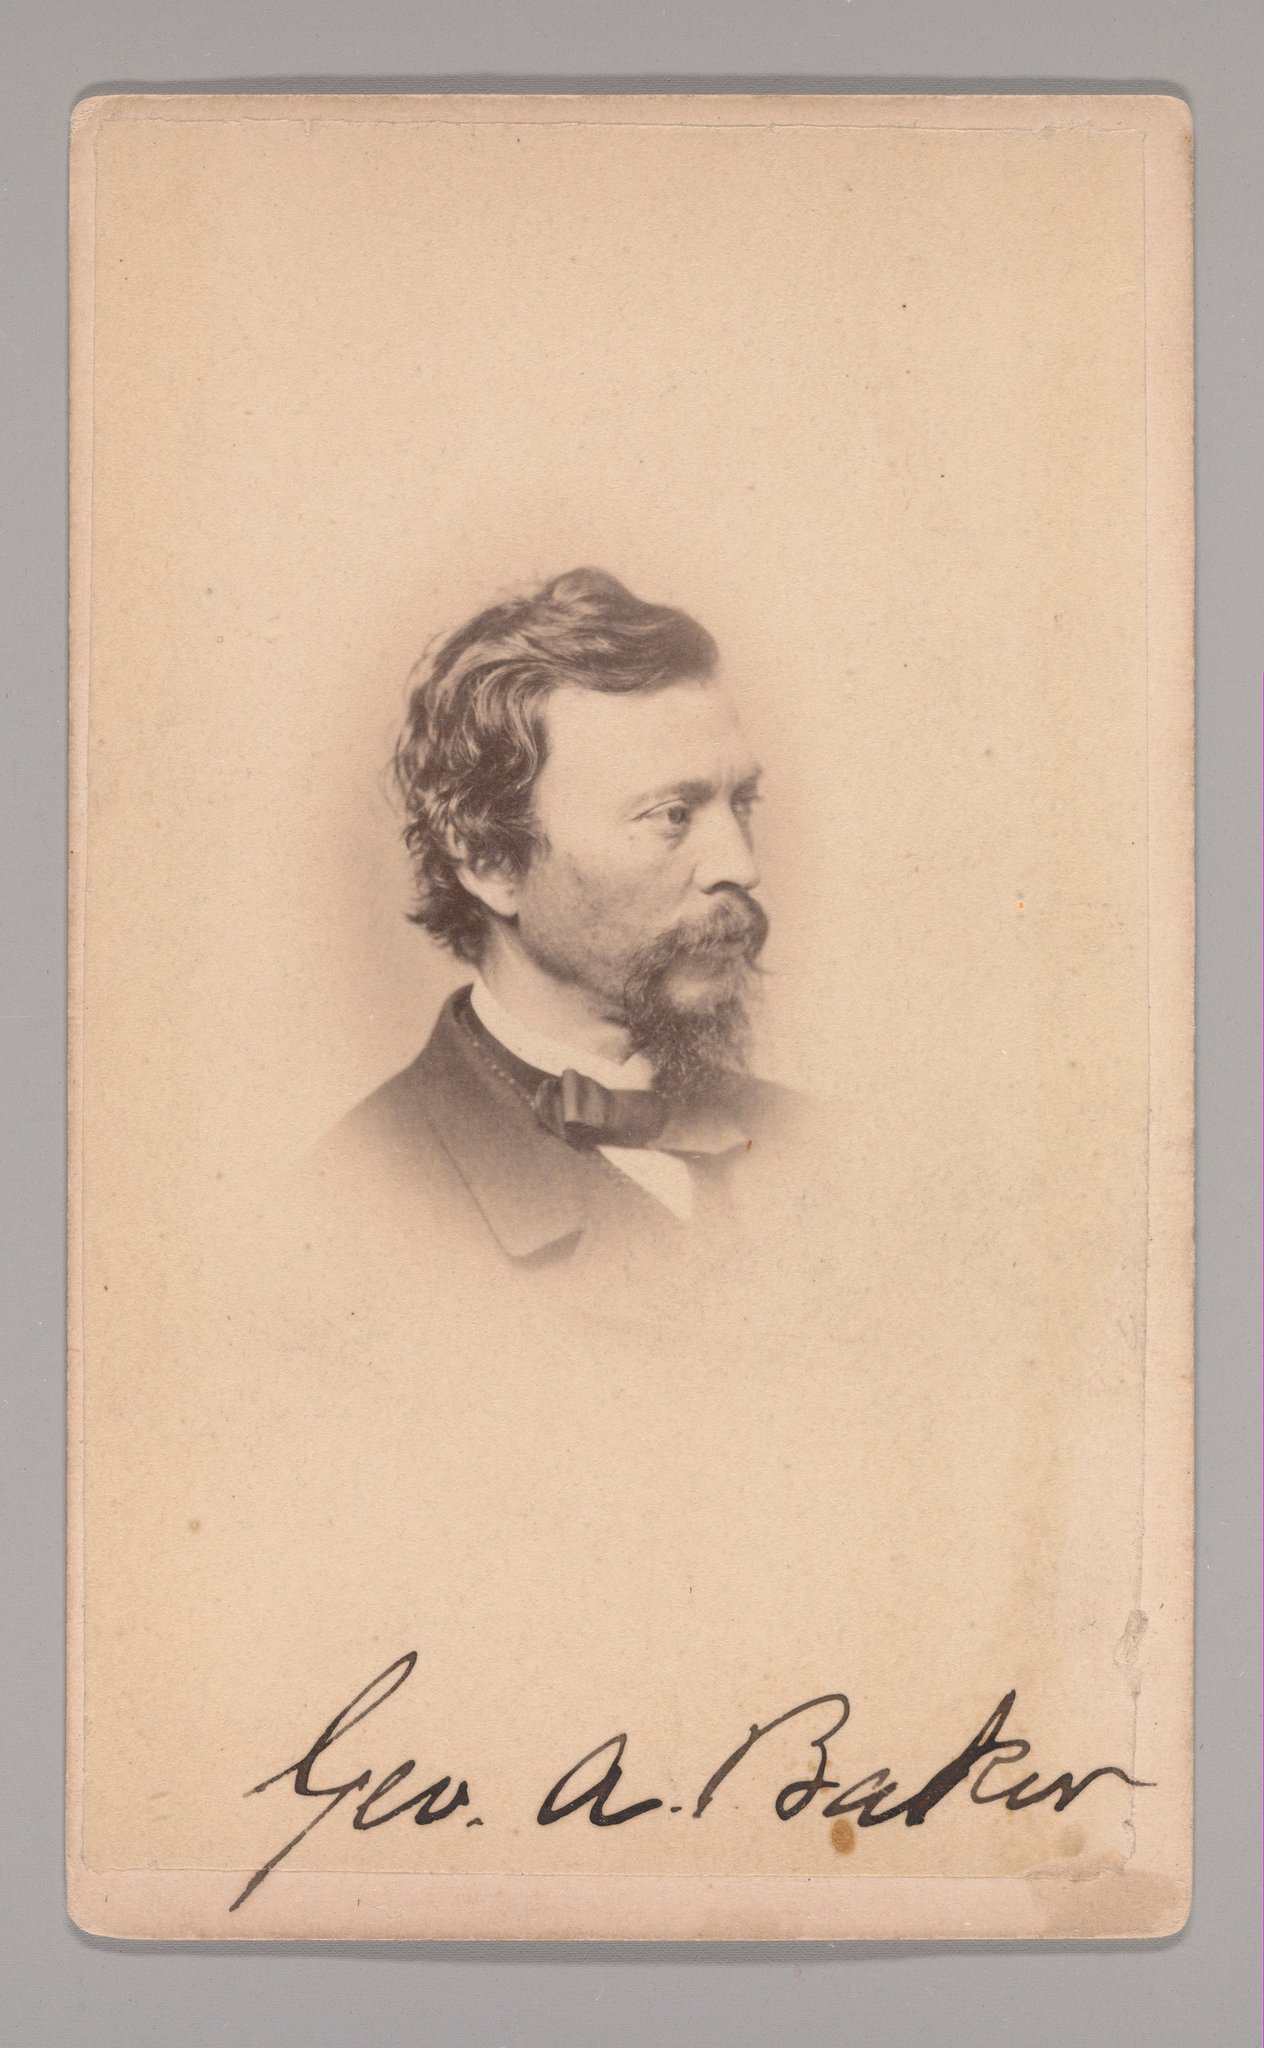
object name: carte de visite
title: [George Augustus Baker]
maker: maurice stadtfeld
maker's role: artist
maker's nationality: american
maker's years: 1860-1869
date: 1860-1869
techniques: albumen silver print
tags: men,portraits